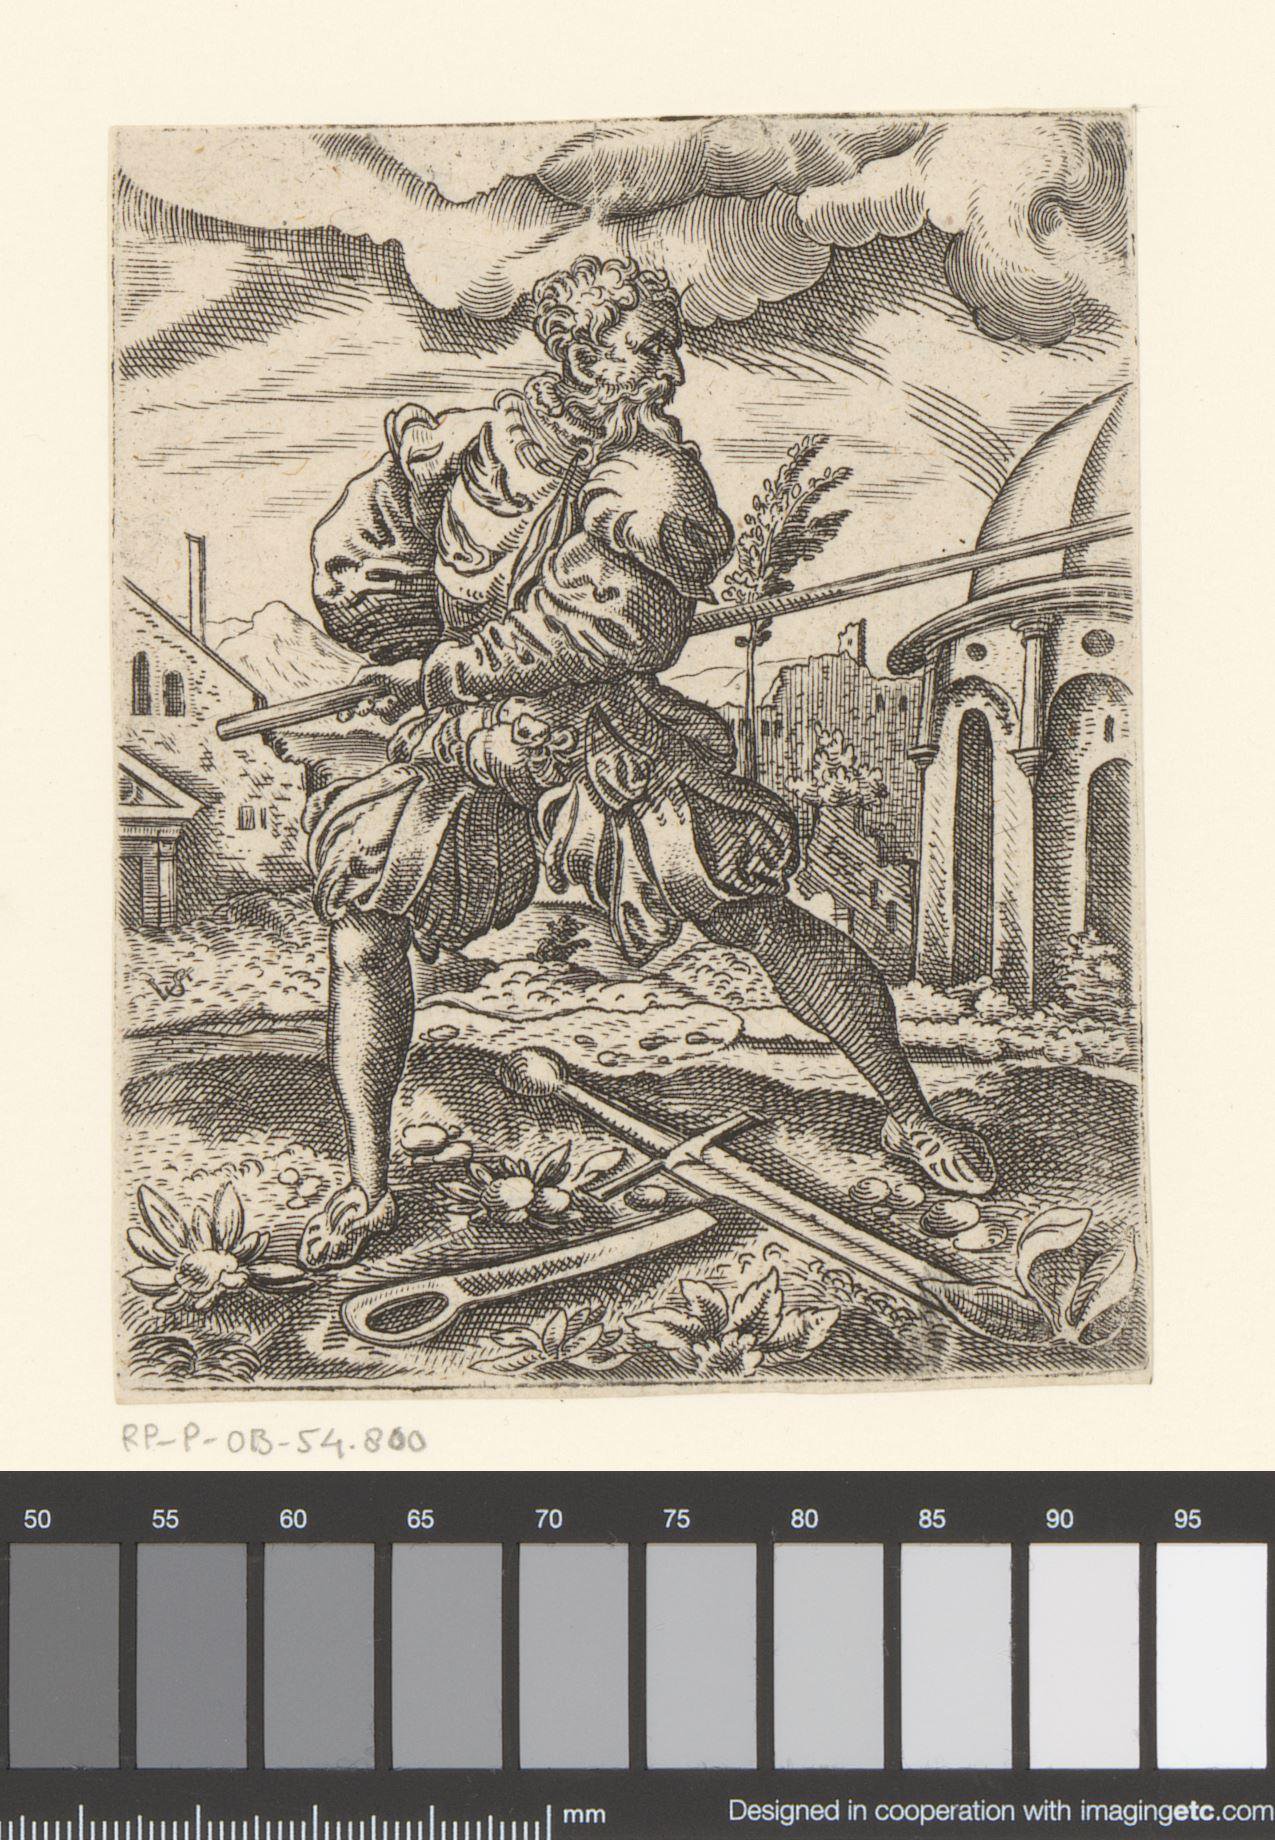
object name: print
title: Landsknechten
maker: virgilius solis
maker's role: draughtsman, print maker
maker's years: 1514-1562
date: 1524-1562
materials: paper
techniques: engraving, etching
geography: nuremberg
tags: city-view in general; 'veduta', ruin of a building ~ architecture, the soldier; the soldier's life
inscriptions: collector's mark: Lugt 2228, number: ‘147’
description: Prent maakt deel uit van een serie van zeven prenten met landsknechten. In de collectie Rijksmuseum bevinden zich twee prenten uit de serie.